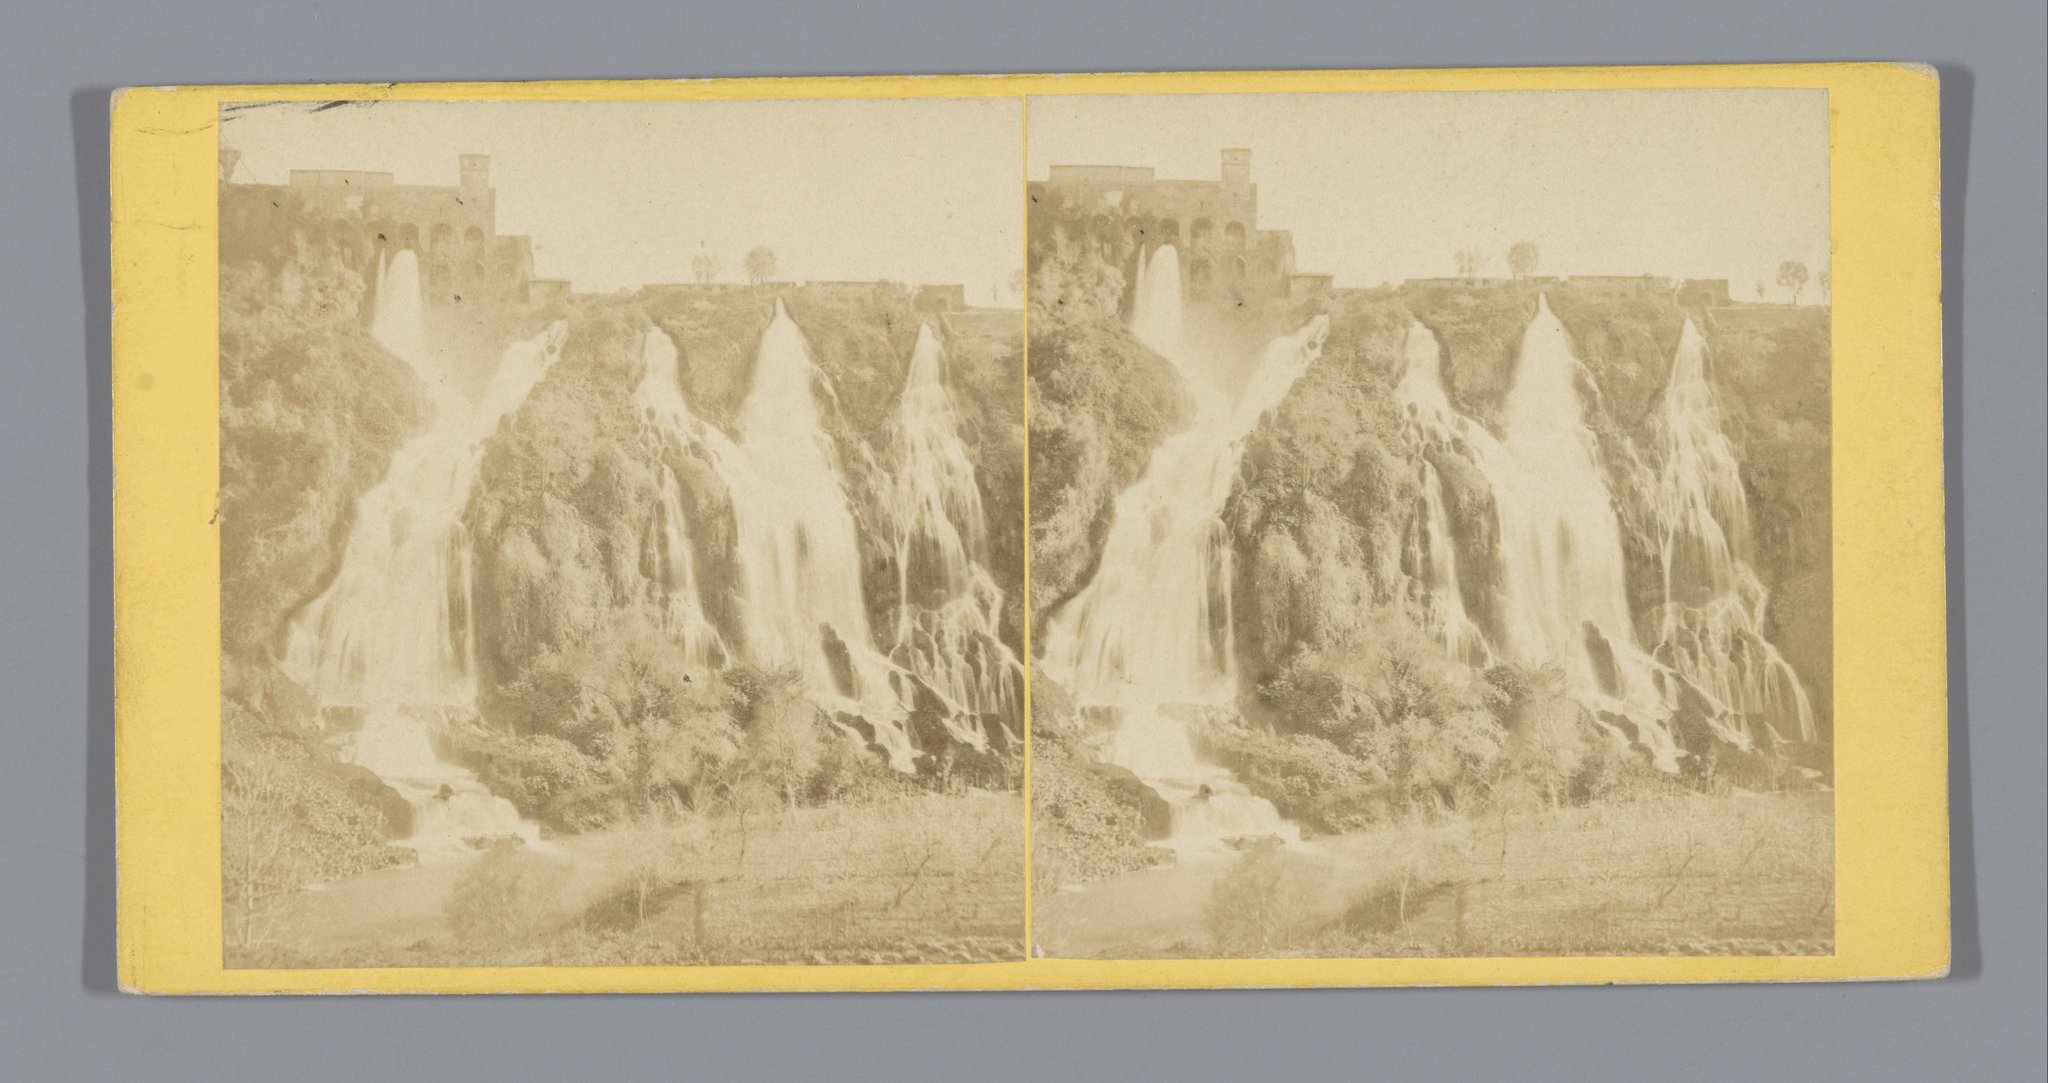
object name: stereograph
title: Watervallen bij Tivoli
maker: Anonymous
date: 1850-1880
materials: cardboard, photographic support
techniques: albumen print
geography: tivoli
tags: waterfall, tivoli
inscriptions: number: ‘986.’